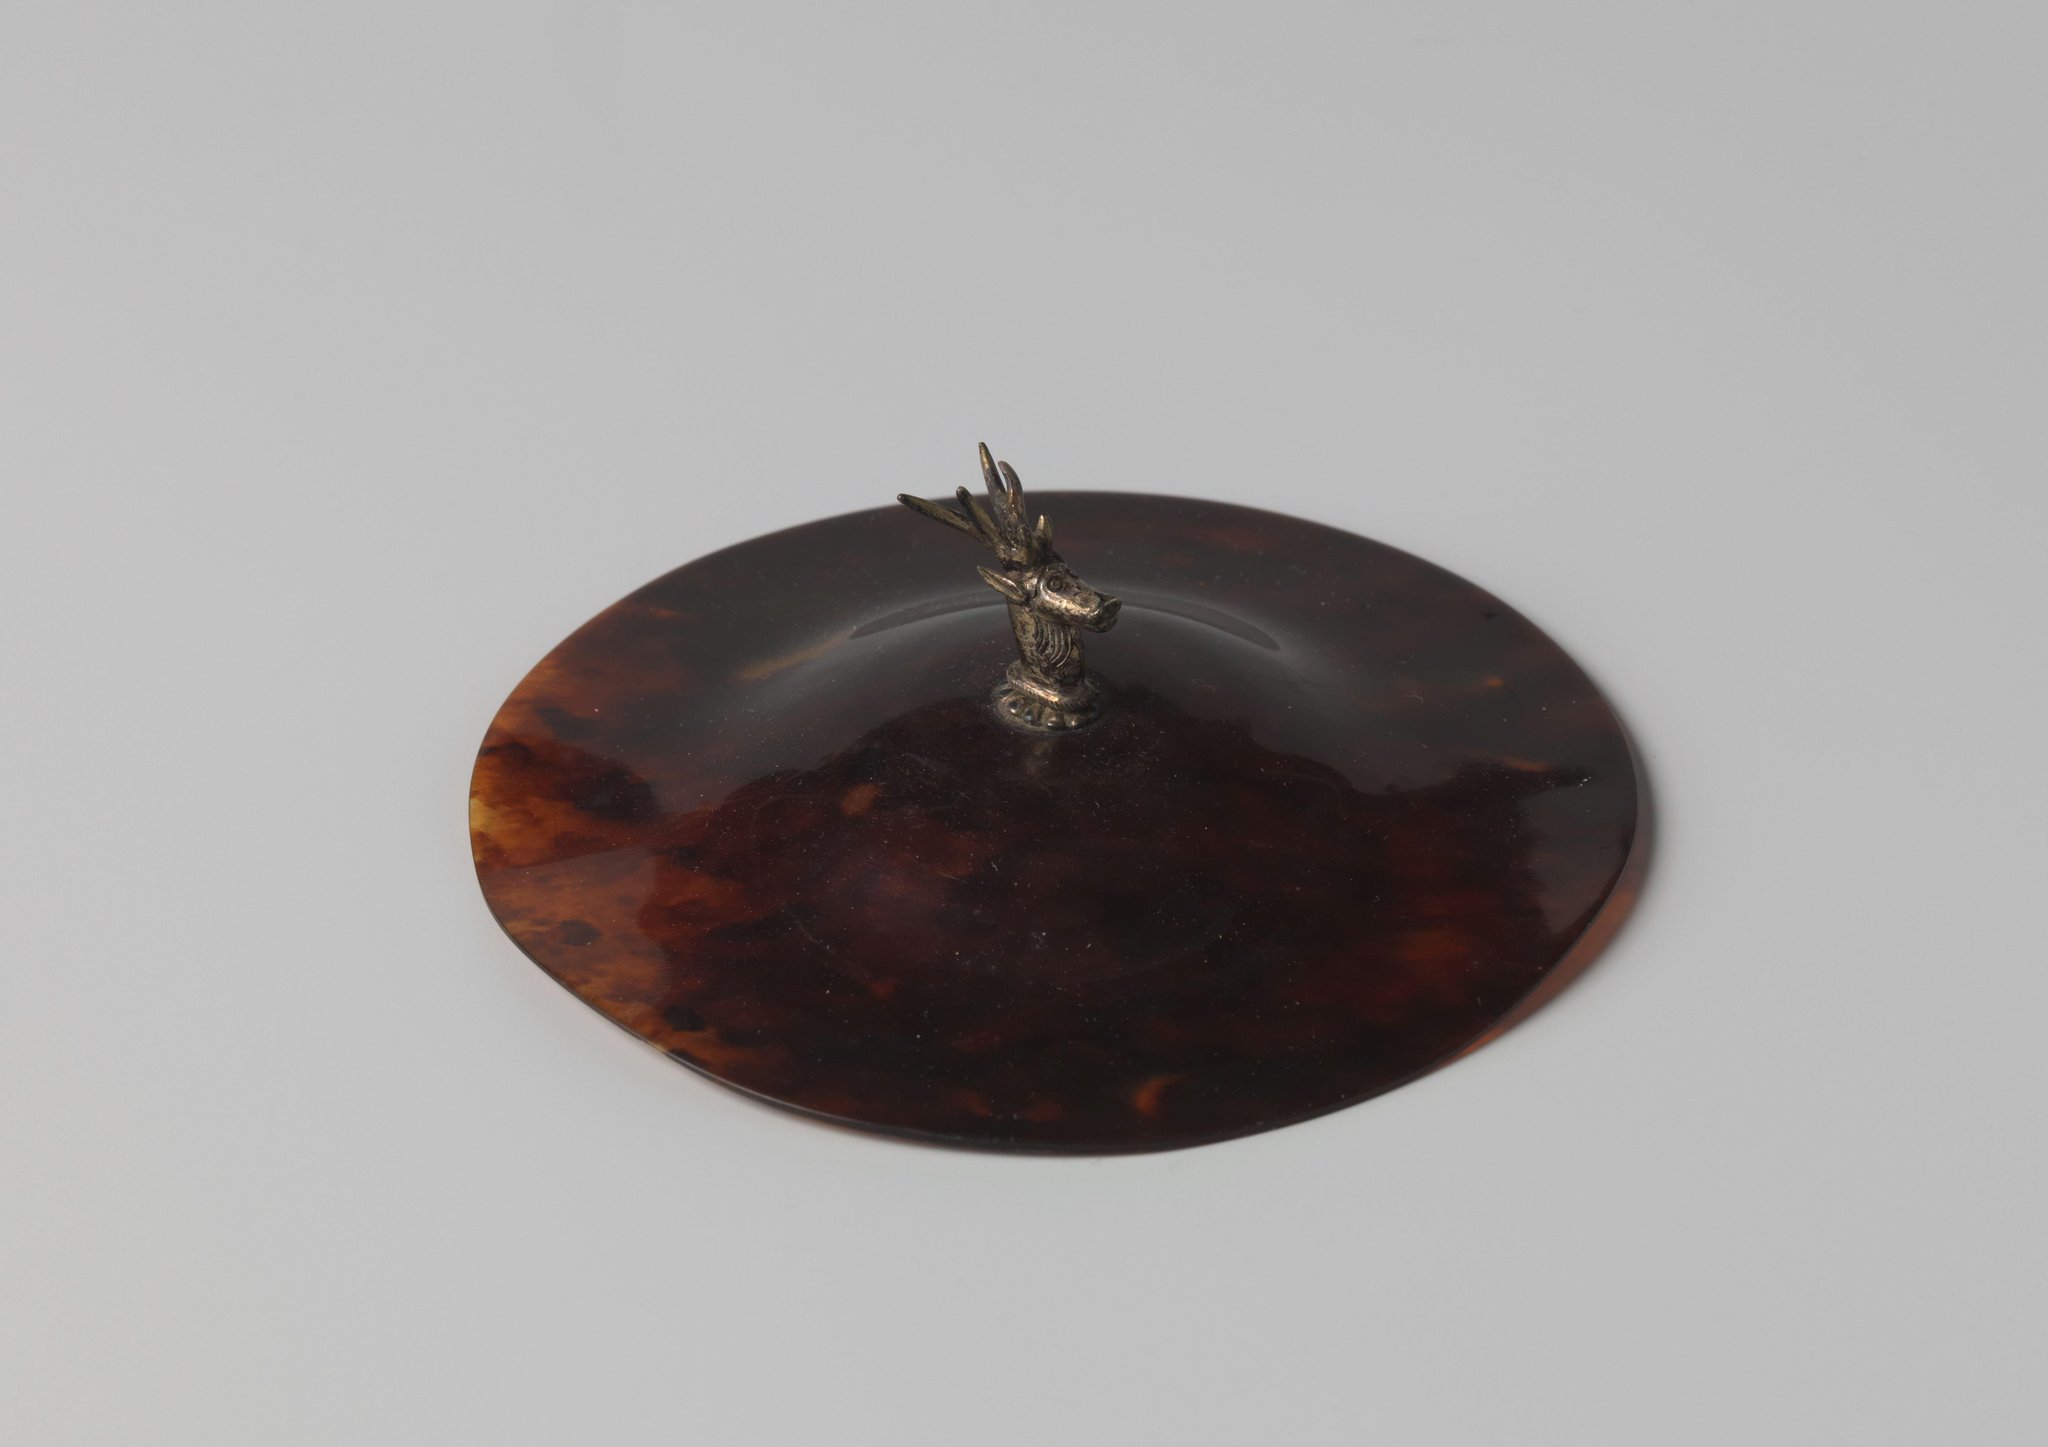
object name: schildpaddeksel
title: Deksel van schildpad met hertekop van zilver (serie van 28 stuks A t/m BB)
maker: Anonymous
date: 1700-1799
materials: silver, shell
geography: indonesia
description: Schildpad-deksel (28 stuks: A t/m BB) met hertekop van zilver als knop.